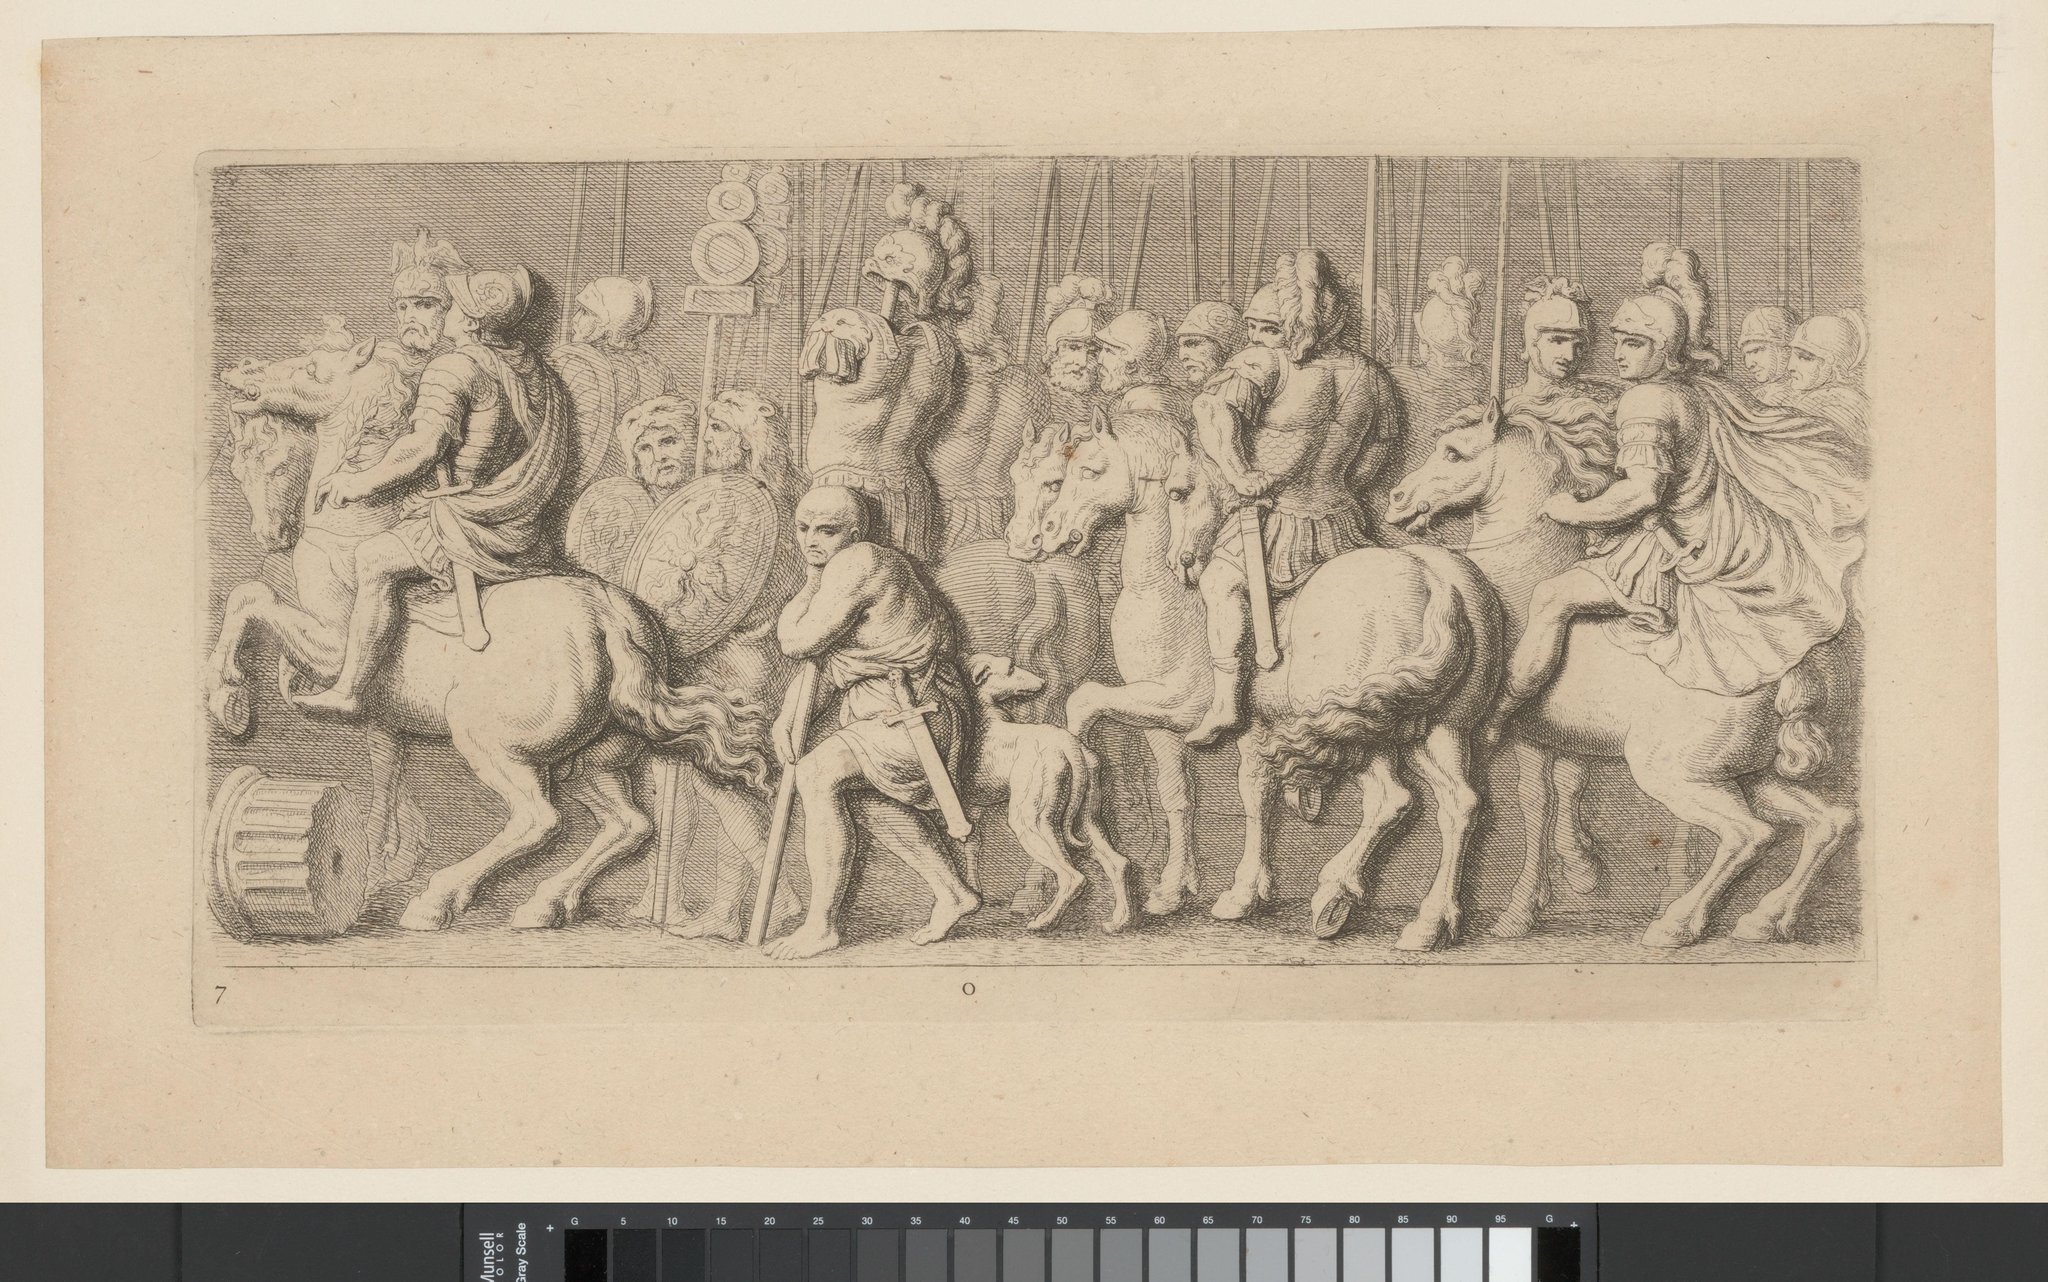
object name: print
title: Fries met triomftocht van Quintus Fabius Maximus op schouw in Burgemeesterskamer van het Stadhuis op de Dam (zevende deel)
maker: hubert quellinus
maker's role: print maker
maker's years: 1619-1687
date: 1663-1668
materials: paper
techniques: engraving, etching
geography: amsterdam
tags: riding a horse, ass, or mule; rider, horseman, triumphs (allegorical and symbolic), conqueror triumphing, triumphal entry of victor, townhall, (military) flags and standards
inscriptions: collector's mark: ‘16,81’ Lugt 1641b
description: Aangezien er meerdere (in ieder geval vier) Quinti Fabii Maximi zijn geweest die consul waren en één of meerdere triomftochten hebben gekregen, is niet met zekerheid te zeggen om welke triomftocht en welke Quintus Fabius Maximus het gaat. Maar het is waarschijnlijk dat het gaat om Quintus Fabius Maximus Verrucosus Cunctator (ca. 275 v.Chr. - 203 v.Chr.), die is afgebeeld op het schilderij van Jan Lievens dat boven de schouw hangt. Op dit schilderij is te zien hoe hij, in 213 v.Chr., op bevel van zijn naamgenoot en zoon Quintus Fabius Maximus - die in dat jaar consul was - van zijn paard afstijgt. Zijn zoon is maar eenmaal consul geweest en heeft geen triomfen behaald. Prent gebruikt in: Secunca pars Praecipuarum effigierum ac ornamentorum amplissime Curiae Amstelrodamensis maiori ex parte in cadido marmore effectorum per Artum Quellinium eiusdem Civitatis Statuarium / Het tweede deel Van de voornaemste Statuen ende Cieraten van 't konst-rijcke Stadt-huys van Amstelredam 'tmeeste in Marmer gemaeckt door Artus Quellinus Beelthouwer der voorseyde Stadt. Amsterdam: Artus Quellinus (I), 1663. Zie RP-P-AO-22-2-1 voor bijhorende titelpagina. Zie RP-P-AO-22-2-2 voor bijhorend register. Zie RP-P-AO-22-2A, RP-P-AO-22-2B, RP-P-AO-22-2C-1, RP-P-AO-22-2C-2, RP-P-AO-22-2C-3, RP-P-AO-22-2C-4, RP-P-AO-22-2D-1, RP-P-AO-22-2D-2, RP-P-AO-22-2D-3, RP-P-AO-22-2E-1, RP-P-AO-22-2E-2, RP-P-AO-22-2E-3, RP-P-AO-22-2E-4, RP-P-AO-22-2F-1, RP-P-AO-22-2F-2, RP-P-AO-22-2F-3, RP-P-AO-22-2G, RP-P-AO-22-2H, RP-P-AO-22-2I, RP-P-AO-22-2K, RP-P-AO-22-2L, RP-P-AO-22-2M, RP-P-AO-22-2N, RP-P-AO-22-2O-1, RP-P-AO-22-2O-2, RP-P-AO-22-2O-3, RP-P-AO-22-2O-4, RP-P-AO-22-2O-5, RP-P-AO-22-2O-6, RP-P-AO-22-2P-1, RP-P-AO-22-2P-2, RP-P-AO-22-2Q-1, RP-P-AO-22-2Q-2, RP-P-AO-22-2Q-3, RP-P-AO-22-2R-1, RP-P-AO-22-2R-2, RP-P-AO-22-2R-3, RP-P-AO-22-2S, RP-P-AO-22-2T-1, RP-P-AO-22-2T-2, RP-P-AO-22-2T-3, RP-P-AO-22-2T-4, RP-P-AO-22-2V-1, RP-P-AO-22-2V-2, RP-P-AO-22-2W-1, RP-P-AO-22-2W-2, RP-P-AO-22-2X-1, RP-P-AO-22-2X-2 en RP-P-AO-22-2X-3 voor andere prenten uit deze publicatie. Zelfde staat van prent ook gebruikt in: Secunca pars Praecipuarum effigierum ac ornamentorum amplissime Curiae Amstelrodamensis maiori ex parte in cadido marmore effectorum per Artum Quellinium eiusdem Civitatis Statuarium / Het tweede deel Van de voornaemste Statuen ende Cieraten van 't konst-rijcke Stadt-huys van Amstelredam 'tmeeste in Marmer gemaeckt door Artus Quellinus Beelthouwer der voorseyde Stadt. Amsterdam: Frederik de Wit, 1668. Latere staat van prent ook gebruikt in: Architecture peinture et sculpture de la Maison de Ville d'Amsterdam, representee en CIX. figures en taille-douce (…). Amsterdam: David Mortier, 1719. En in: Architecture peinture et sculpture de la Maison de Ville d'Amsterdam, representee en CIX. figures en taille-douce (…). Amsterdam: Gerard Valck, 1719. En in: Bouw schilder en beeldhouwkonst, van het Stadhuis te Amsteldam, vertoont in CIX figuuren (…). Amsterdam: Covens & Mortier & Covens Jr., s.a. (1774-1783).